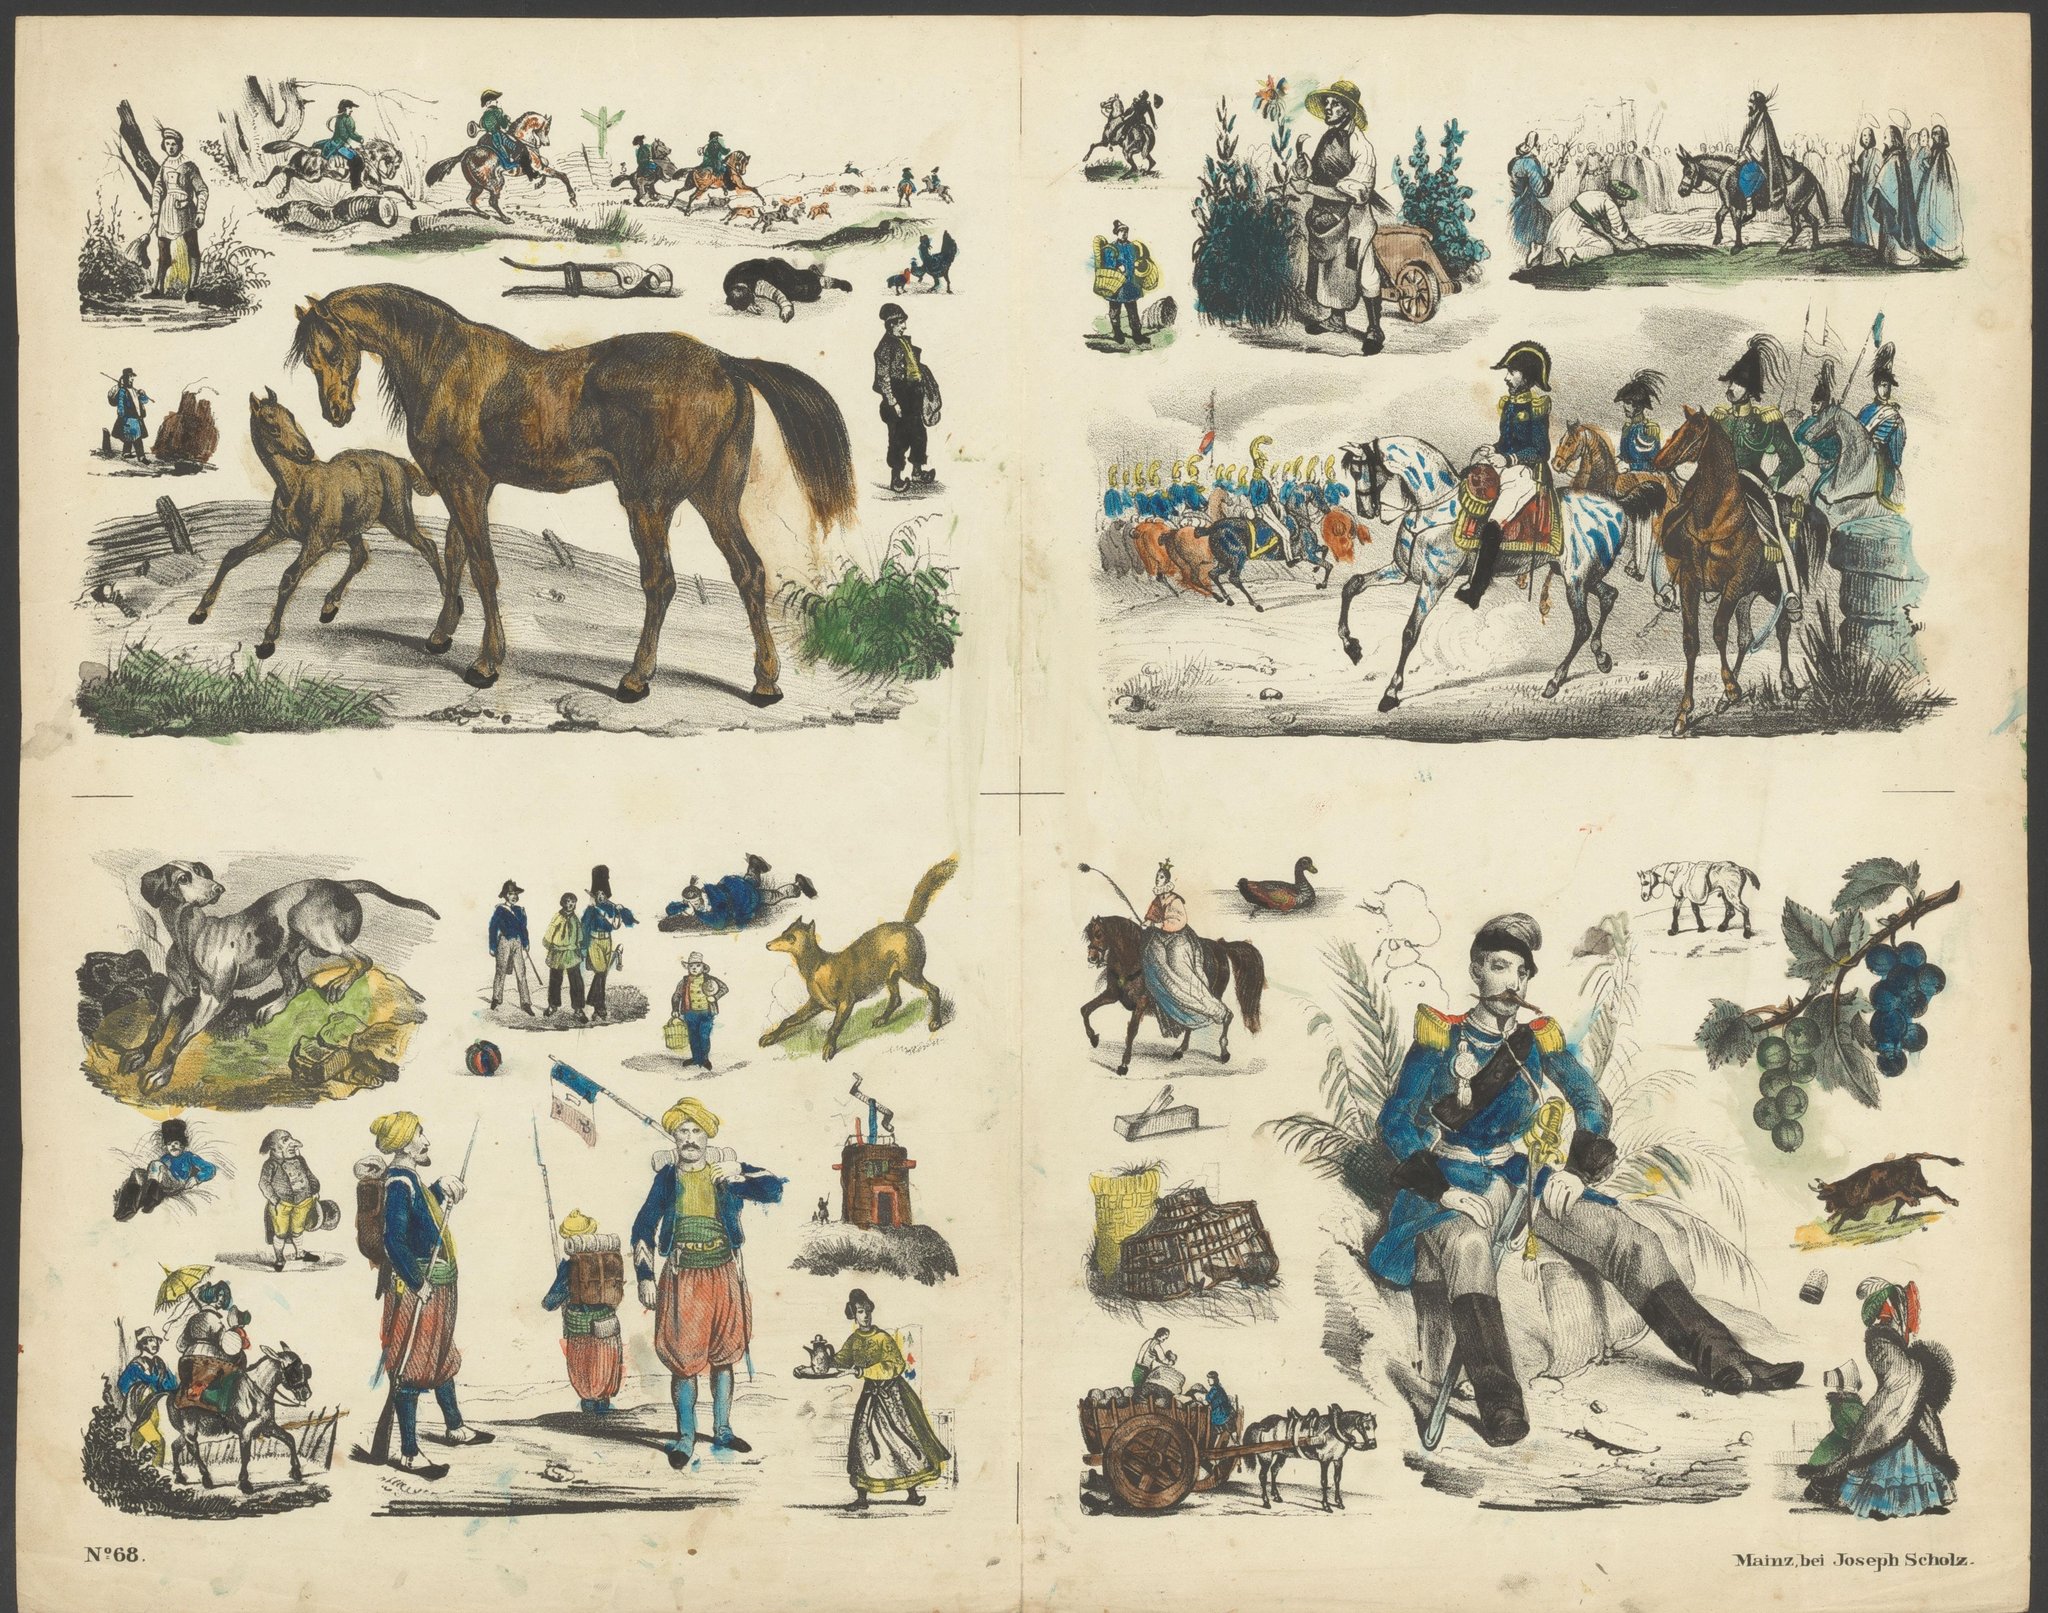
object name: print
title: Reizigers, militairen en een stier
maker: Anonymous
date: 1800-1899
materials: paper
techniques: hand coloring, lithograph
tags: the soldier; the soldier's life, horse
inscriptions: stamp, collector's mark: Lugt 1641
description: Vier voorstellingen van reizigers, militairen en een stier. Rechtsonder genummerd: No. 87. Onderwerpsrubrieken binnen de Atlas Zeden en Gewoonten: Zeden en Gewoonten in Engeren Zin, Des menschen beging, midden en einde, Kinderleven – Kinderspel en Kinderprenten.